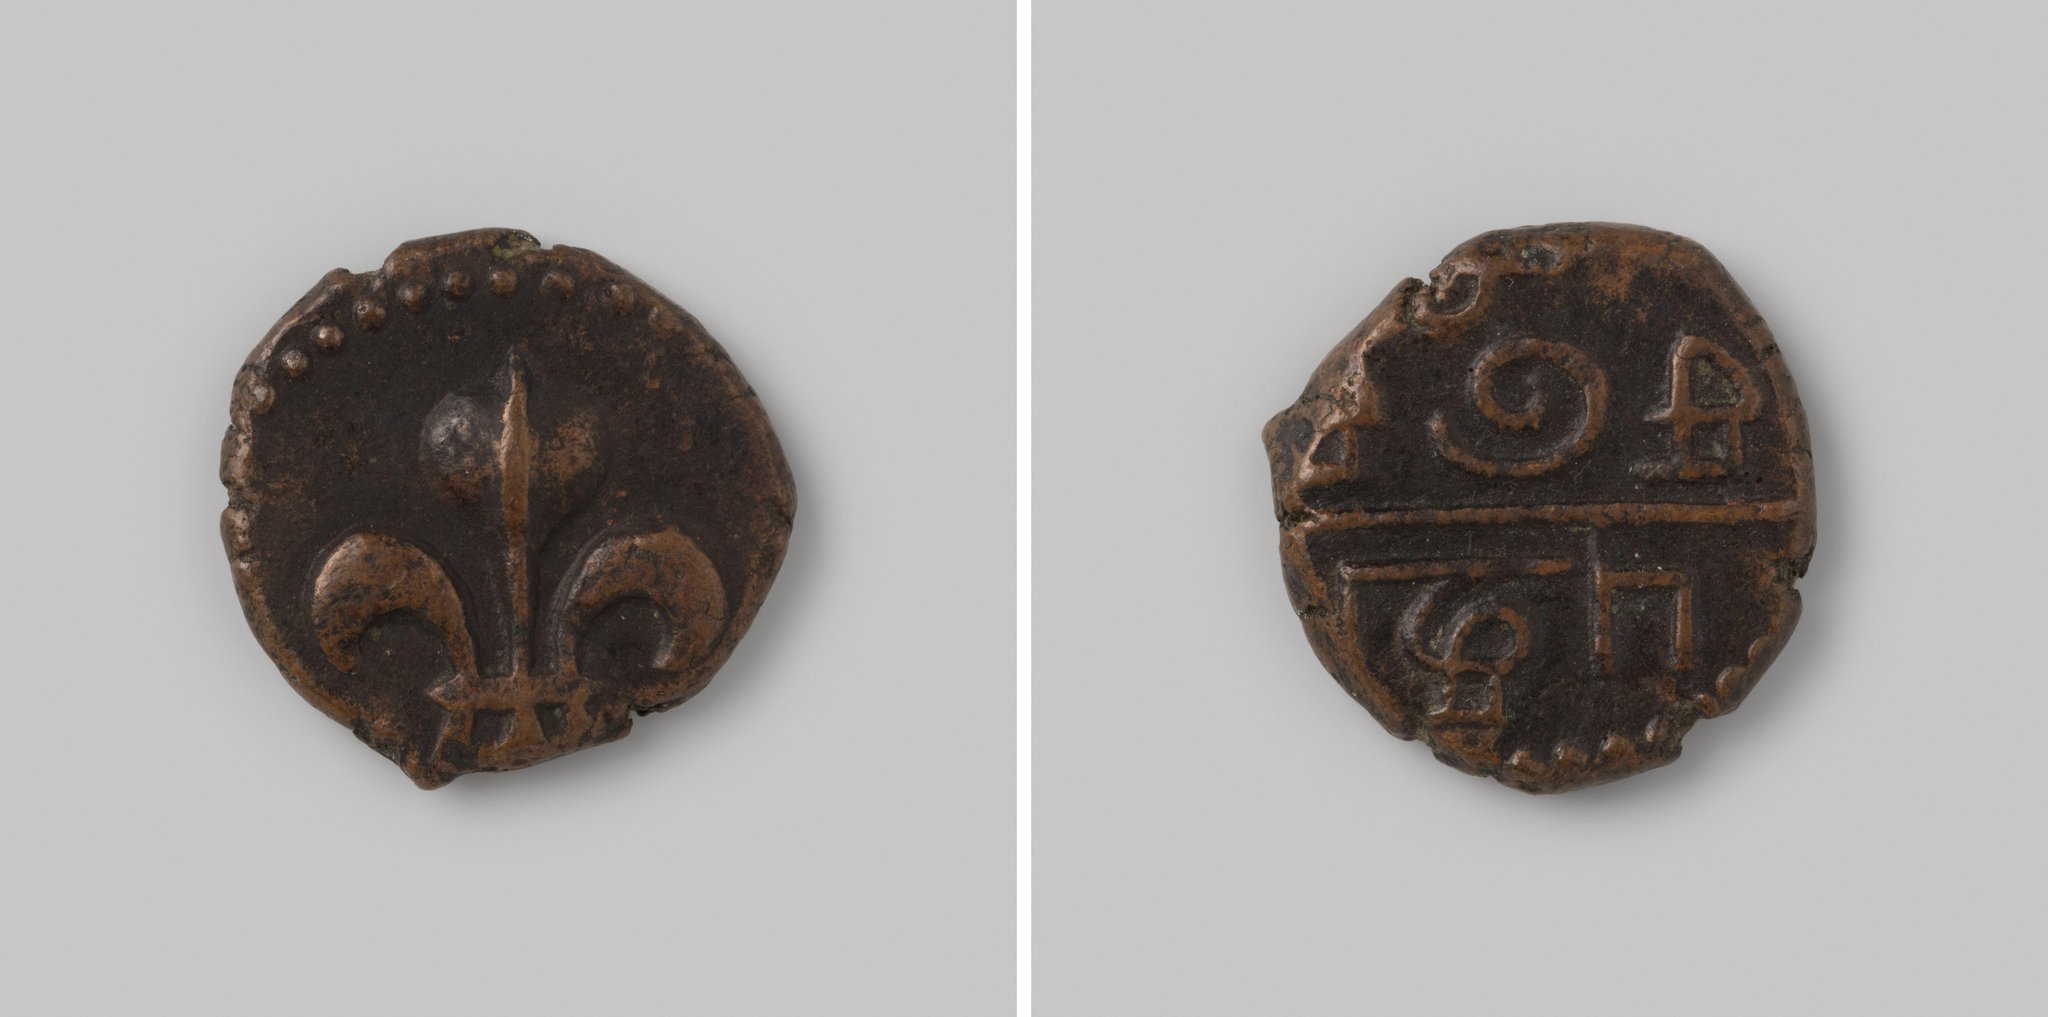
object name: coin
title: Doudou uit Pondicherry in India van de Franse Compagnie perpétuelle des Indes,1720-1837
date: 1720-1837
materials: copper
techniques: striking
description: Koperen munt. Voorzijde: lelie. Keerzijde: in Tamil-schrift in drie regels naam van de muntplaats: Pondicherry.